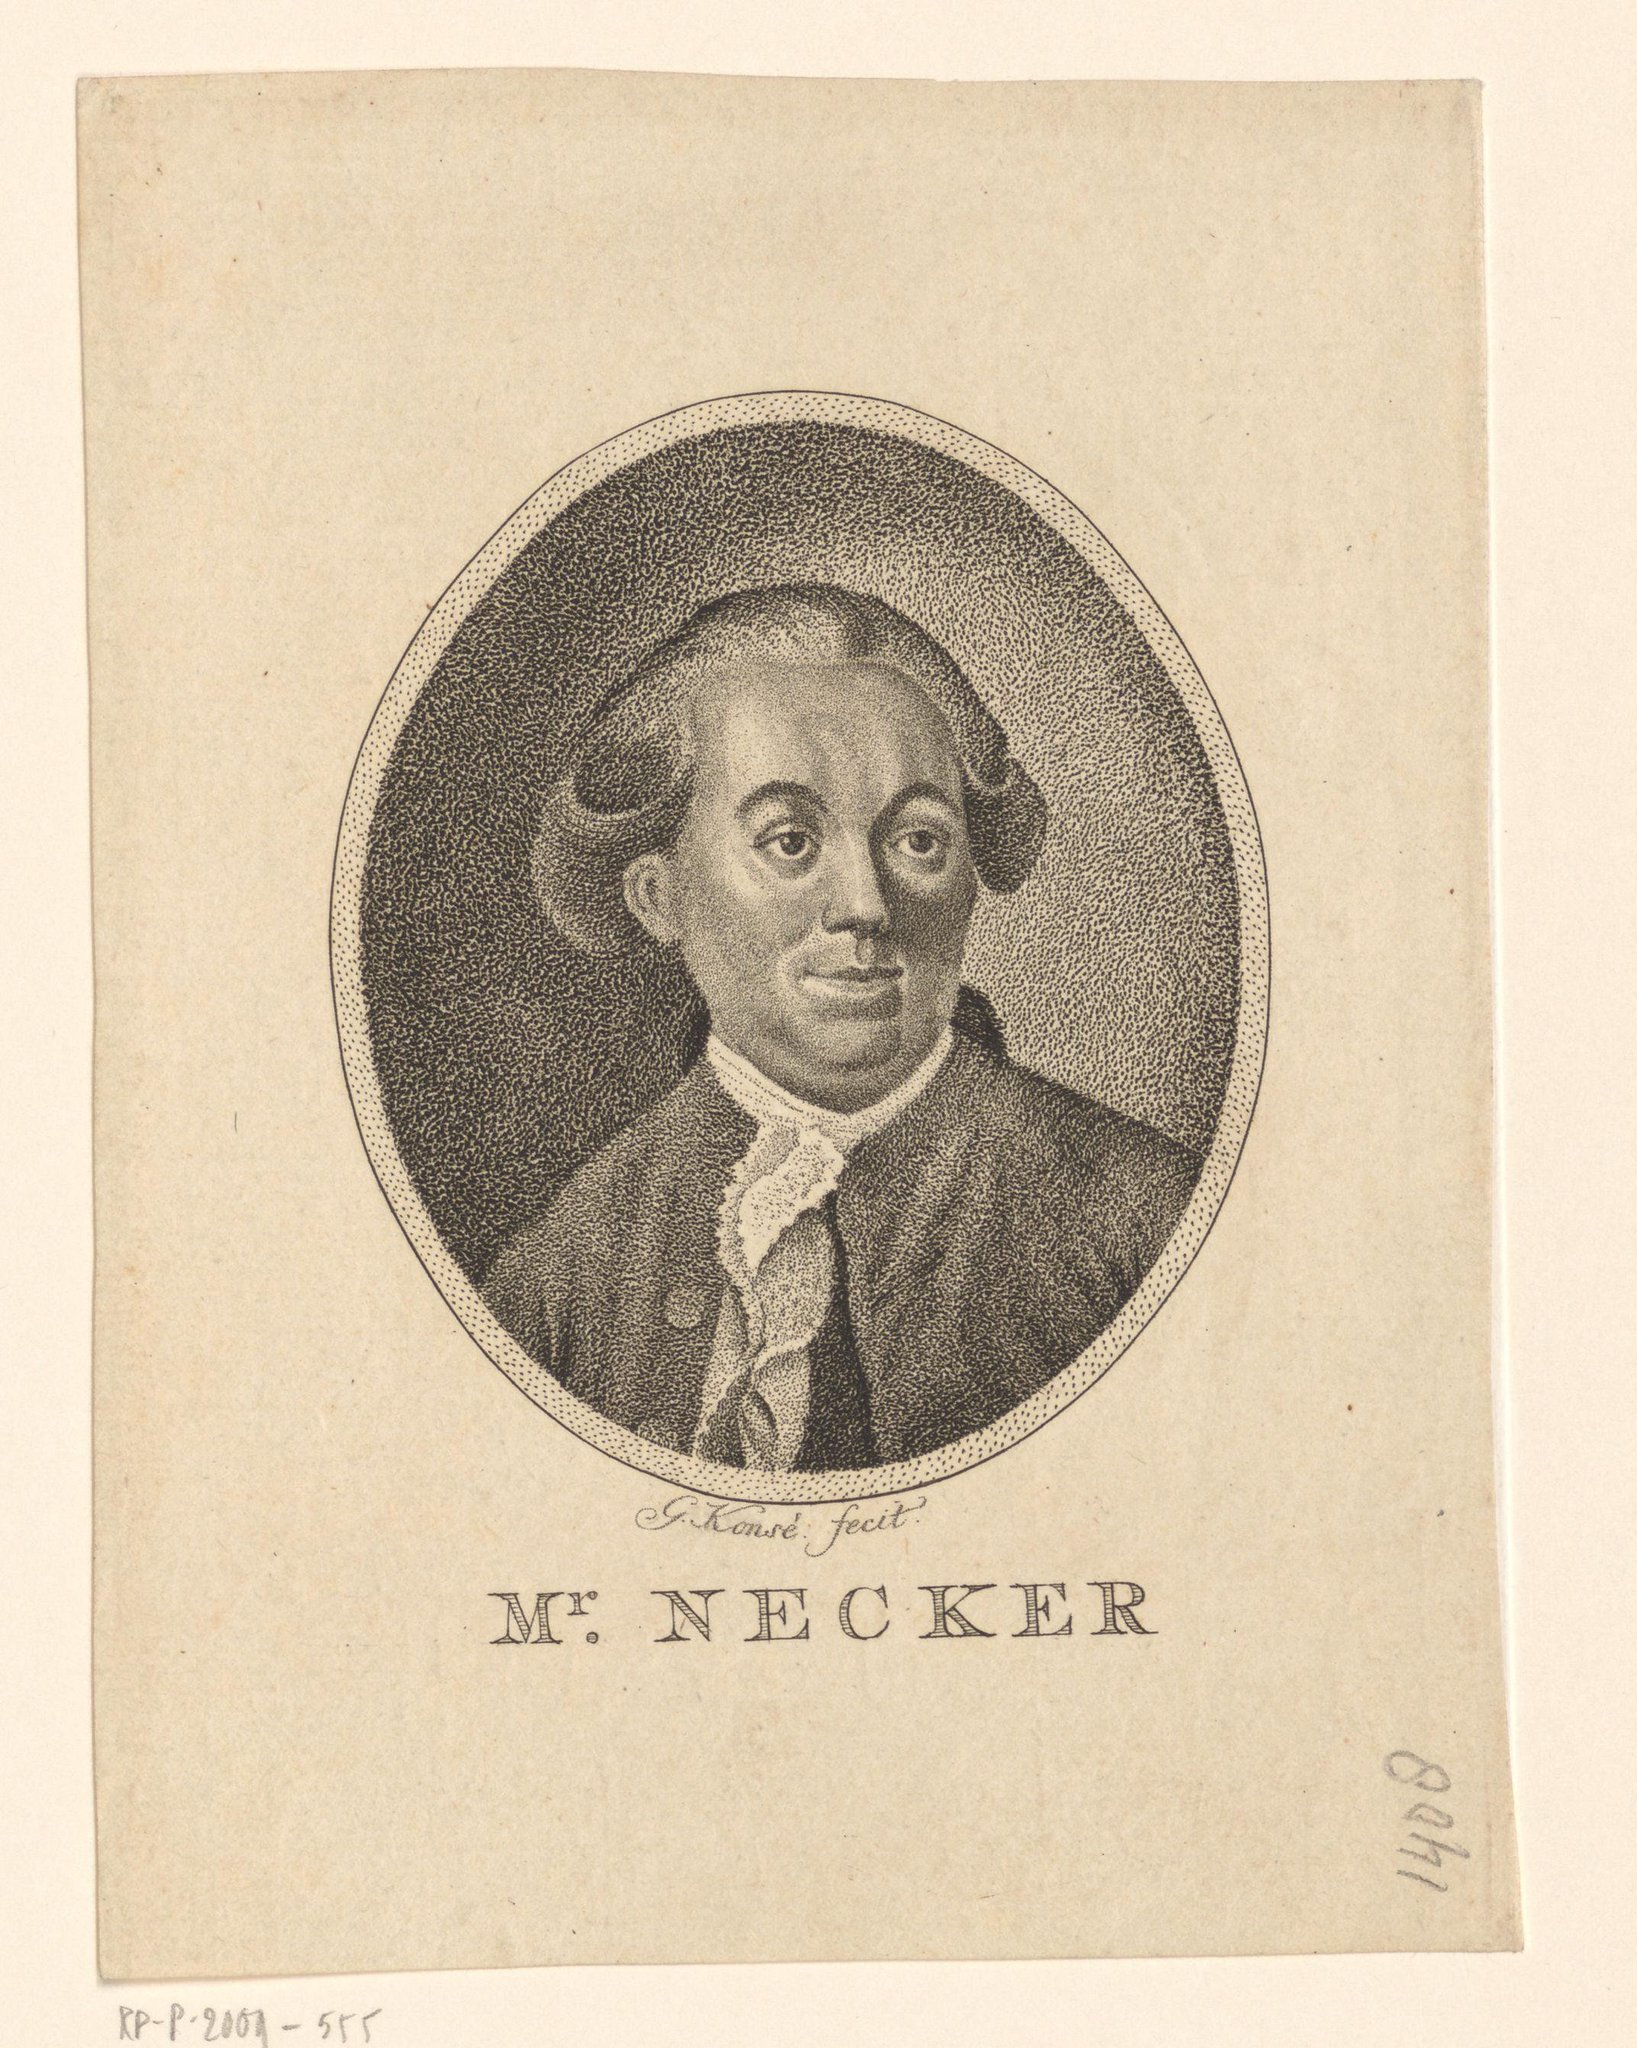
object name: print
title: Portret van Jacques Necker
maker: gerrit konsé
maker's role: print maker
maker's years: 1751-1826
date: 1761-1826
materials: paper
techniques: engraving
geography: amsterdam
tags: minister ~ government, historical persons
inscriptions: collector's mark: Lugt 2228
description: Jacques Necker (30 September 1732 – 9 April 1804) was Frans staatsman van Zwitserse geboorte. Onder Lodewijk XVI was hij minister van financiën. Buste in ovaal, naar rechts. Onder ovaal zijn naam.